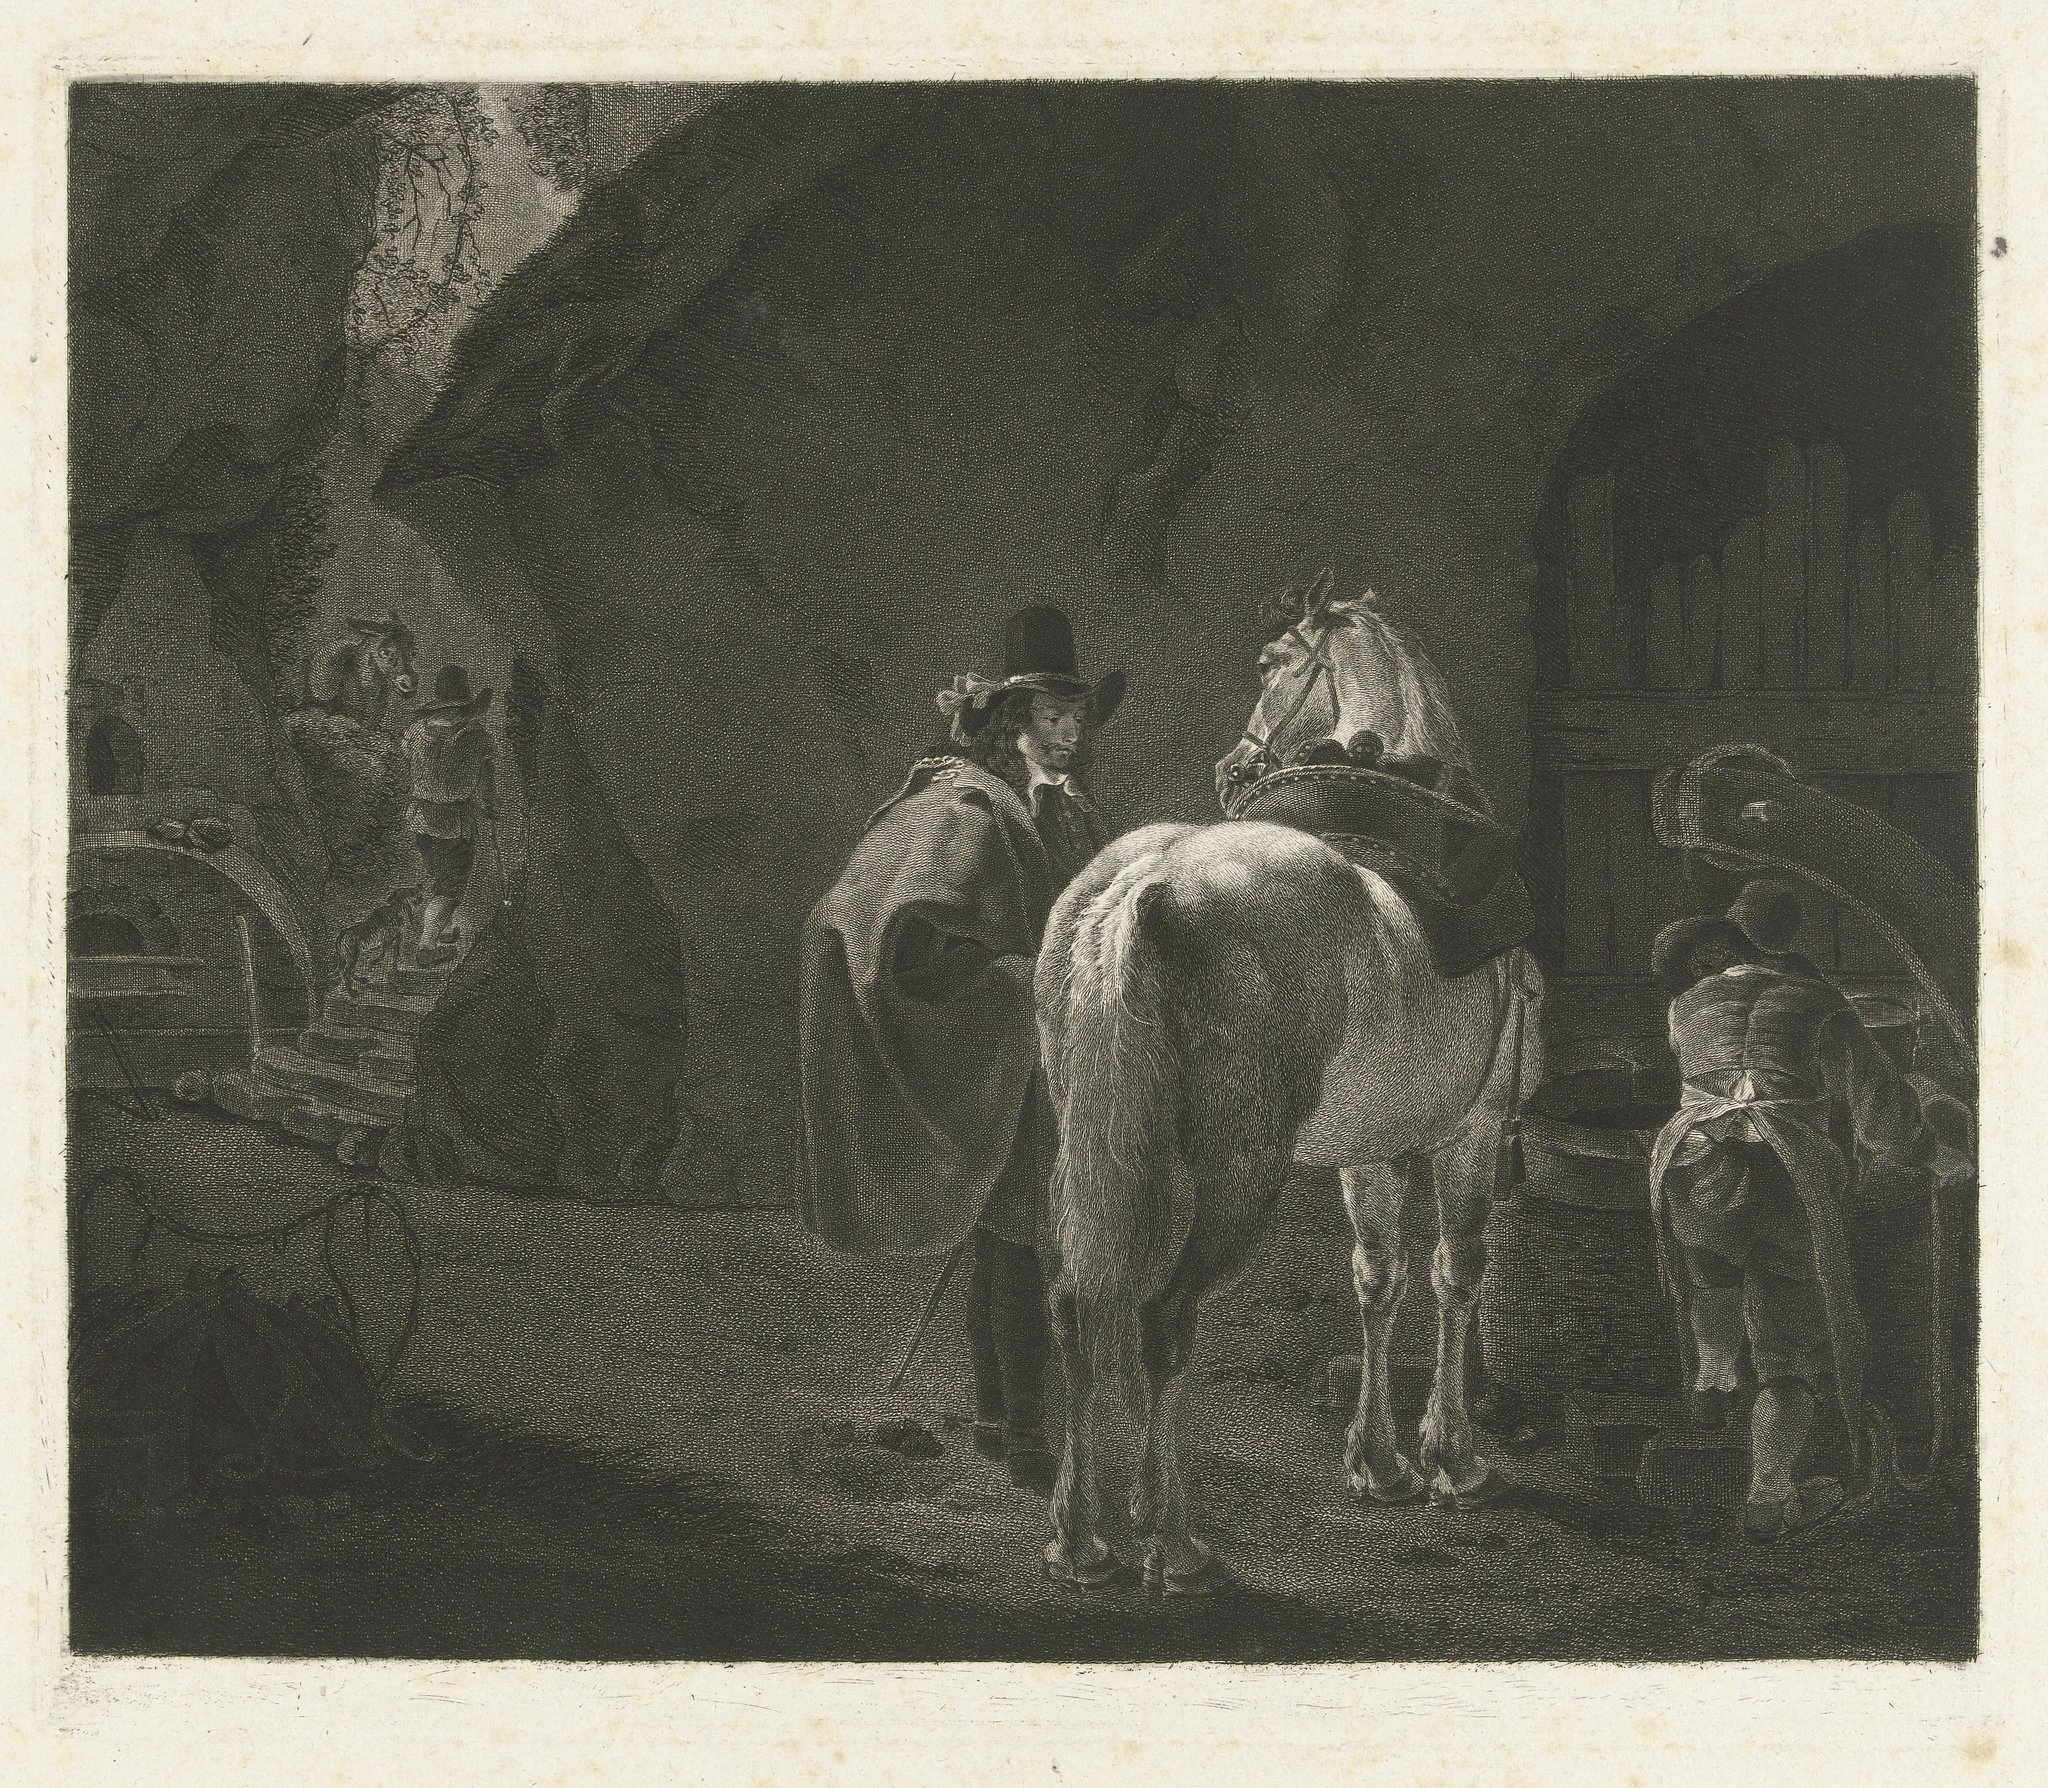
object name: print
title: De Reiziger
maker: lambertus antonius claessens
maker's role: draughtsman, print maker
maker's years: 1763-1834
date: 1800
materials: paper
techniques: etching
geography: amsterdam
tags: giving water, feeding (cattle), 'en route', traveller under way, hotel, hostelry, inn, grooming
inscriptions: collector's mark: Lugt 2228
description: Een reiziger staat in het donker voor een herberg en verzorgd zijn paard. Een knecht haalt water voor het paard uit een bron. Links leidt een trap naast de oven naar de stal waar al een ezel staat.